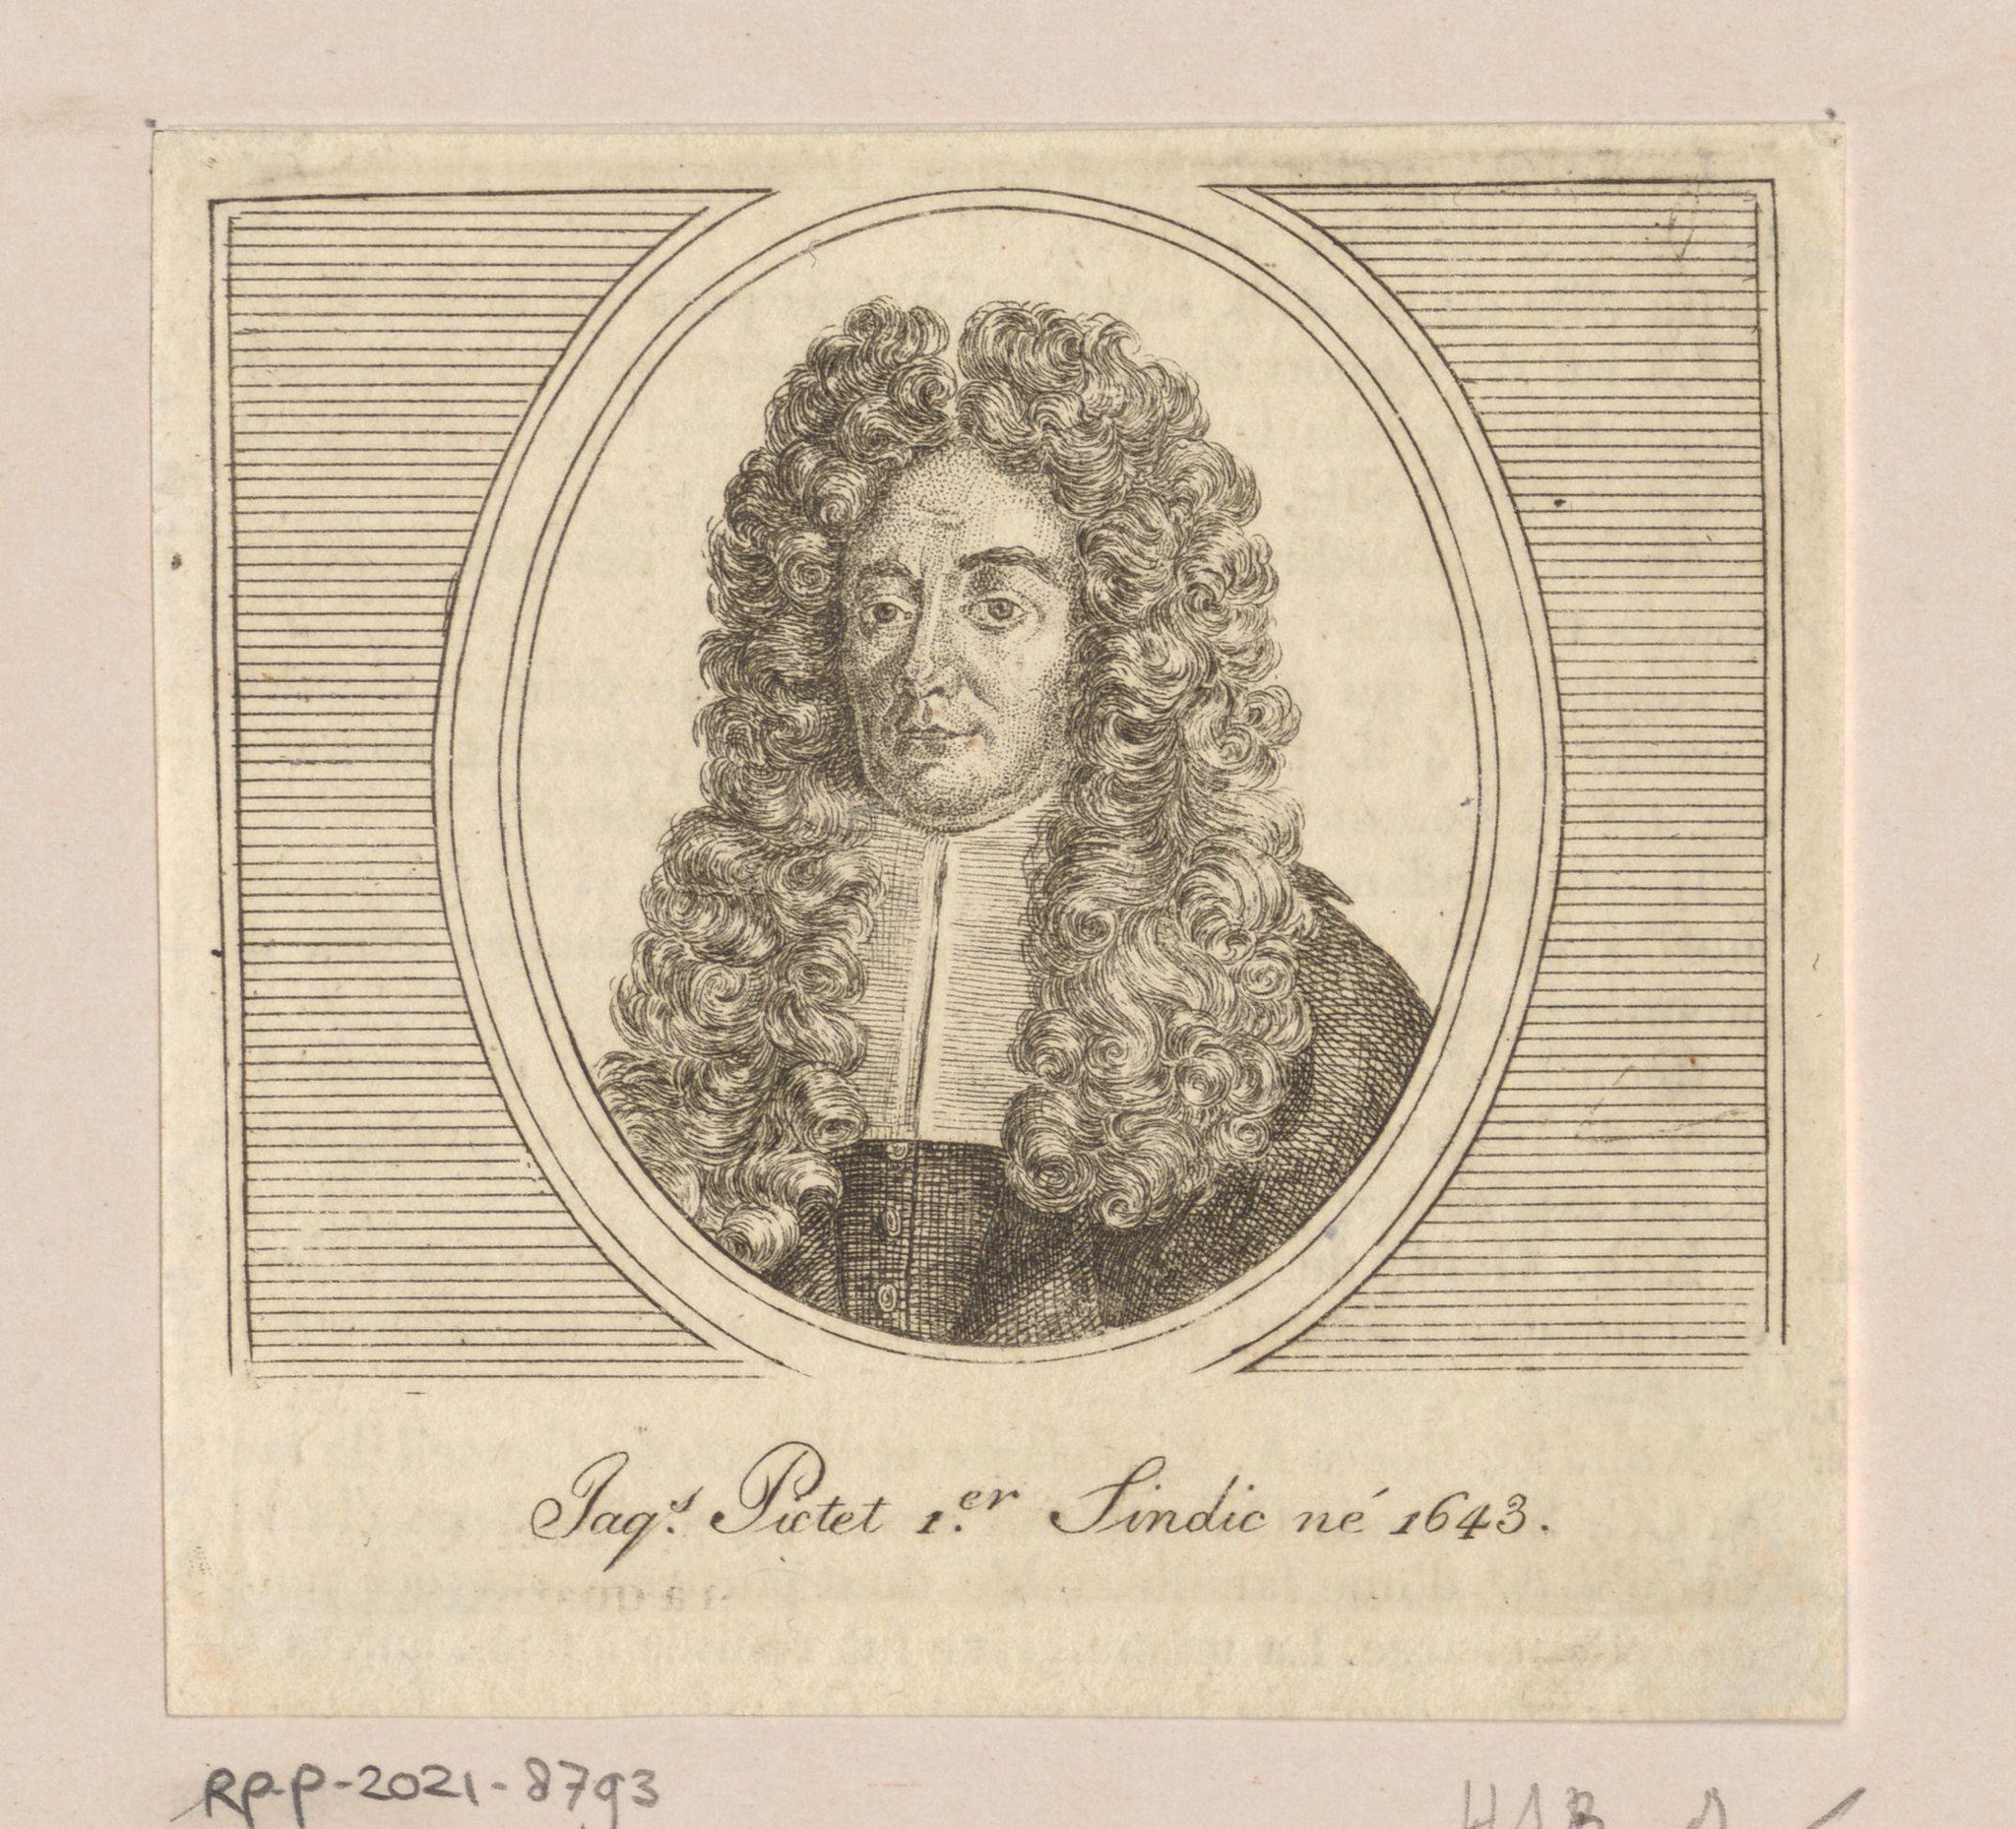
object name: print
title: Portret van Jacques Pictet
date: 1815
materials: paper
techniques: engraving, etching, letterpress printing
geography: geneva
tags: adult man, historical persons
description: Prent uit: Grenus, Théodore de. Fragmens biographiques et historiques: extraits des registres du Conseil d'Etat de la République de Genève, dès 1535 à 1792. Genève: Manget et Cherbuliez, 1815.